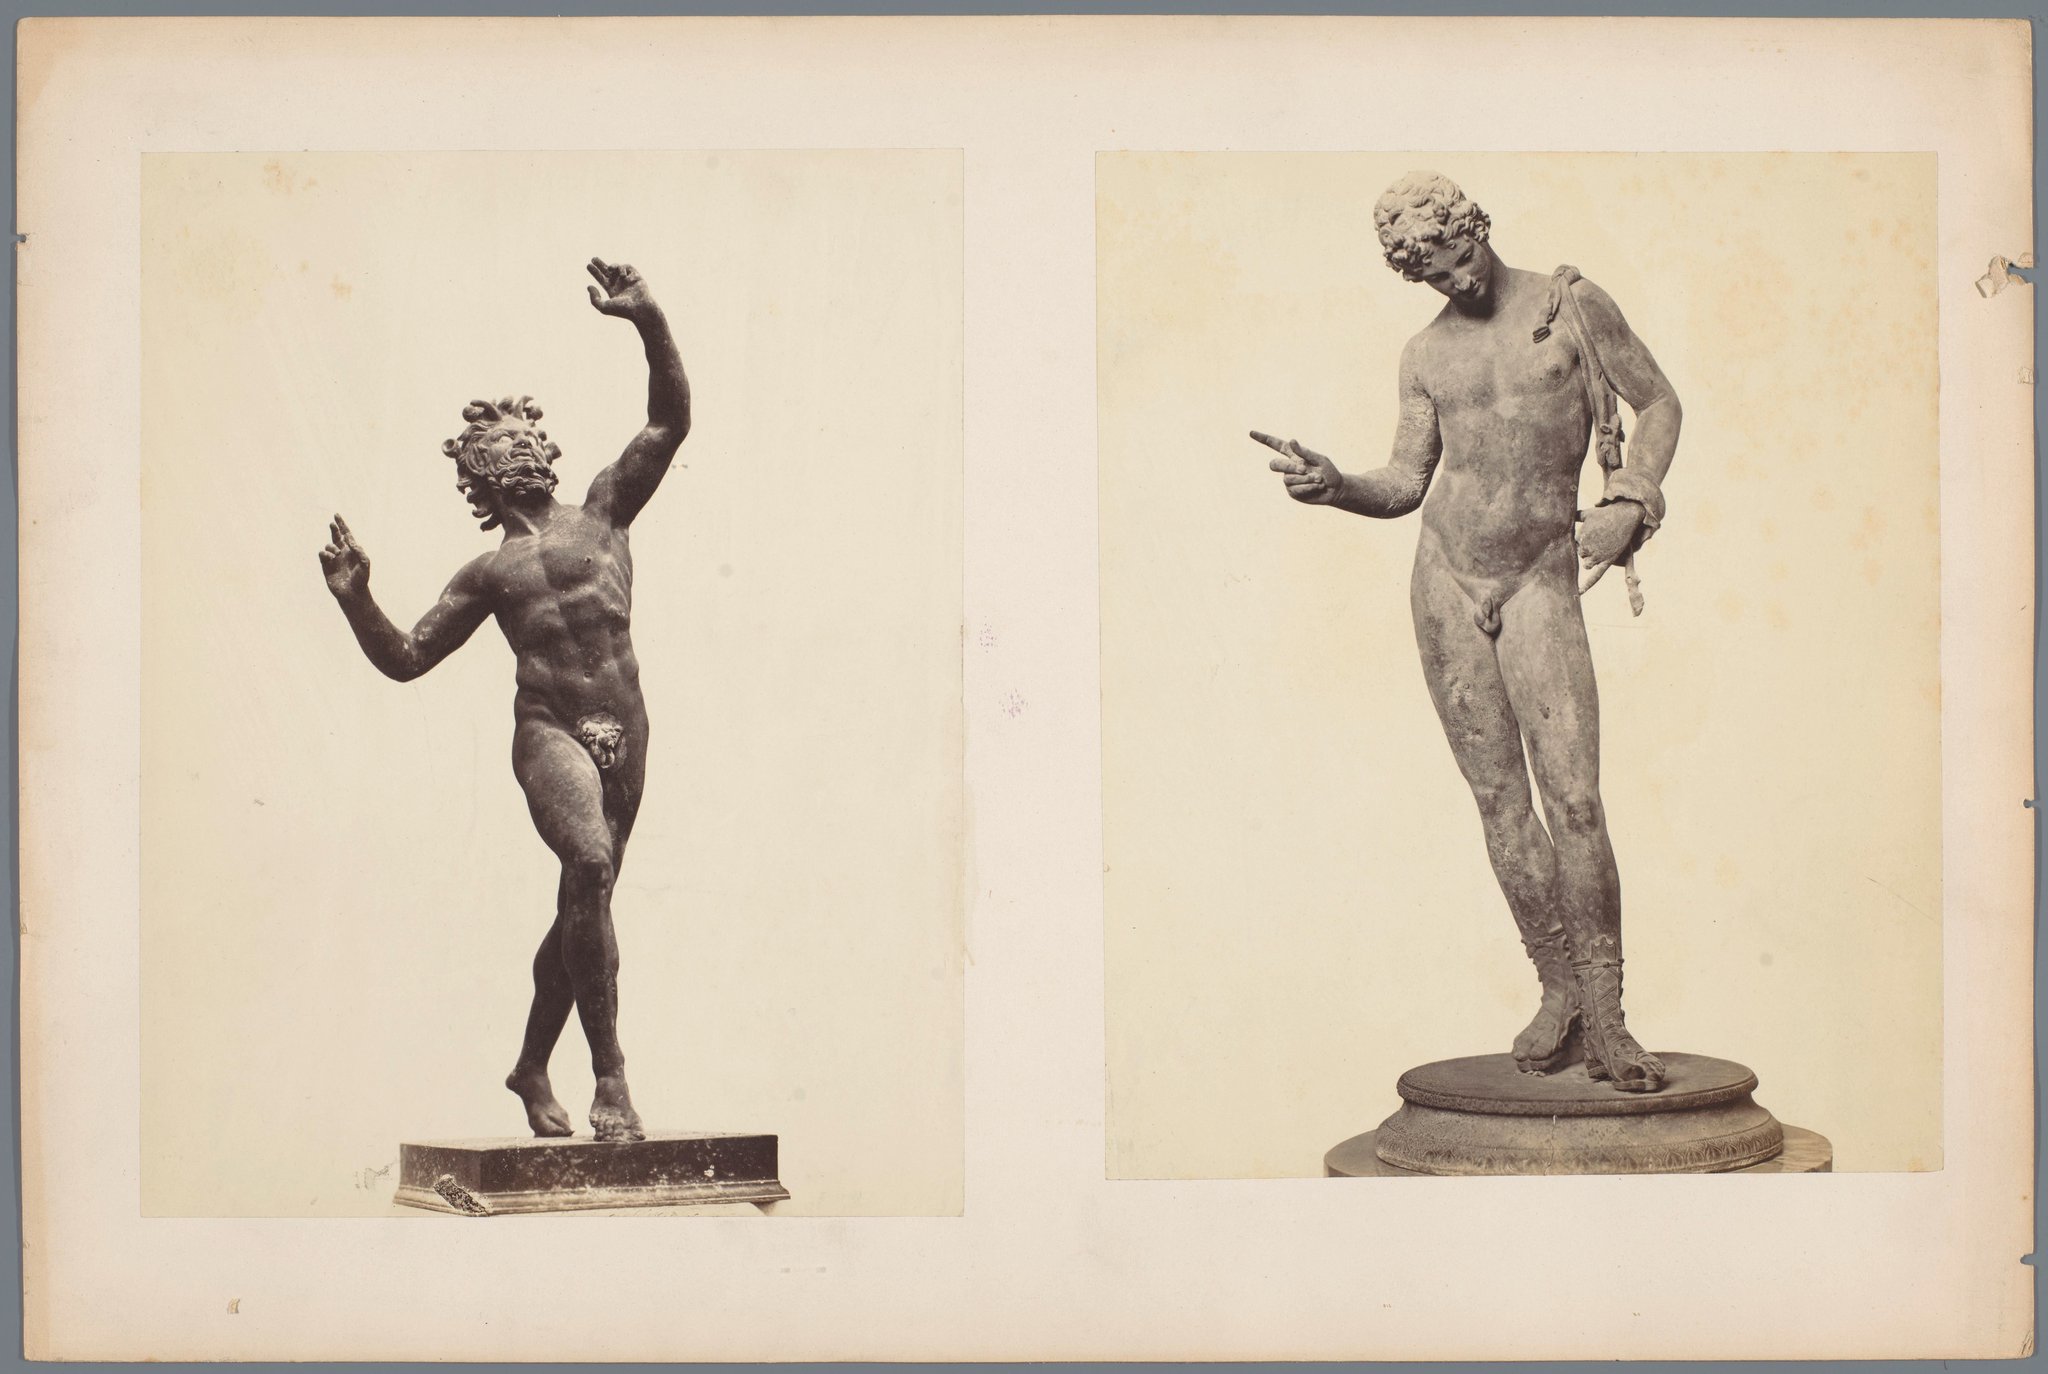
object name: photograph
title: Kerkstoel van notenhout in het Rijksmuseum te Amsterdam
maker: Anonymous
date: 1875-1900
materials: photographic support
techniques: matte daylight collodion silver print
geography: amsterdam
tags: chair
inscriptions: number: ‘LI kat 251 145 C’, collector's mark: ‘Instituut voor kunst-nijverheidsonderwijs Gabriël Metsustraat No. 16, Amsterdam’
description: Zie voor het originele object BK-NM-10751.